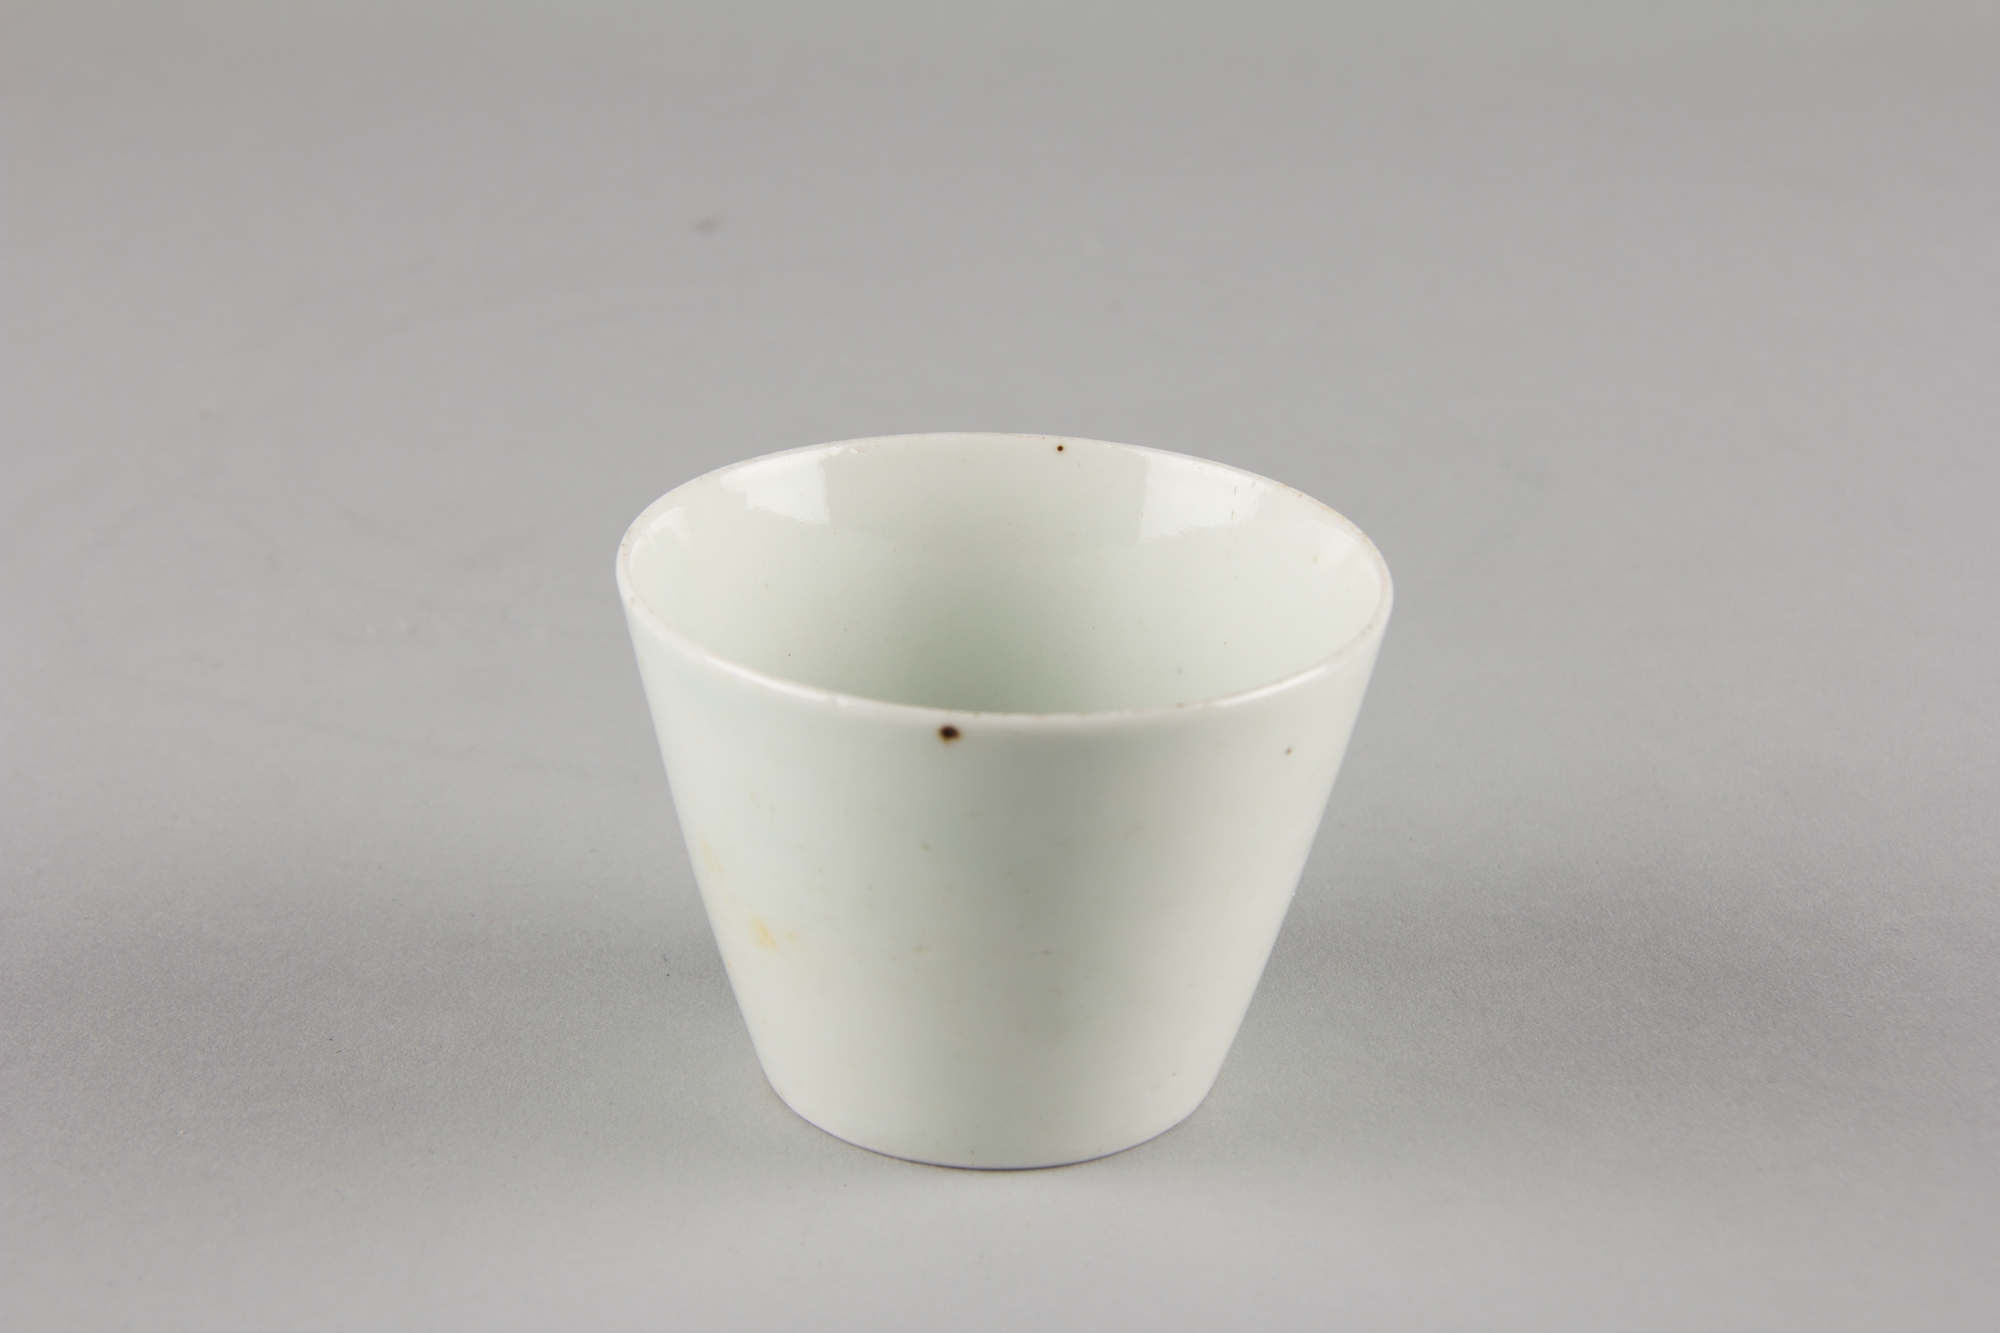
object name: soba cup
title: One from a Set of Five Soba Cups with Chrysanthemum Design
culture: japanese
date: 1615-1868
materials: porcelain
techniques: underglaze